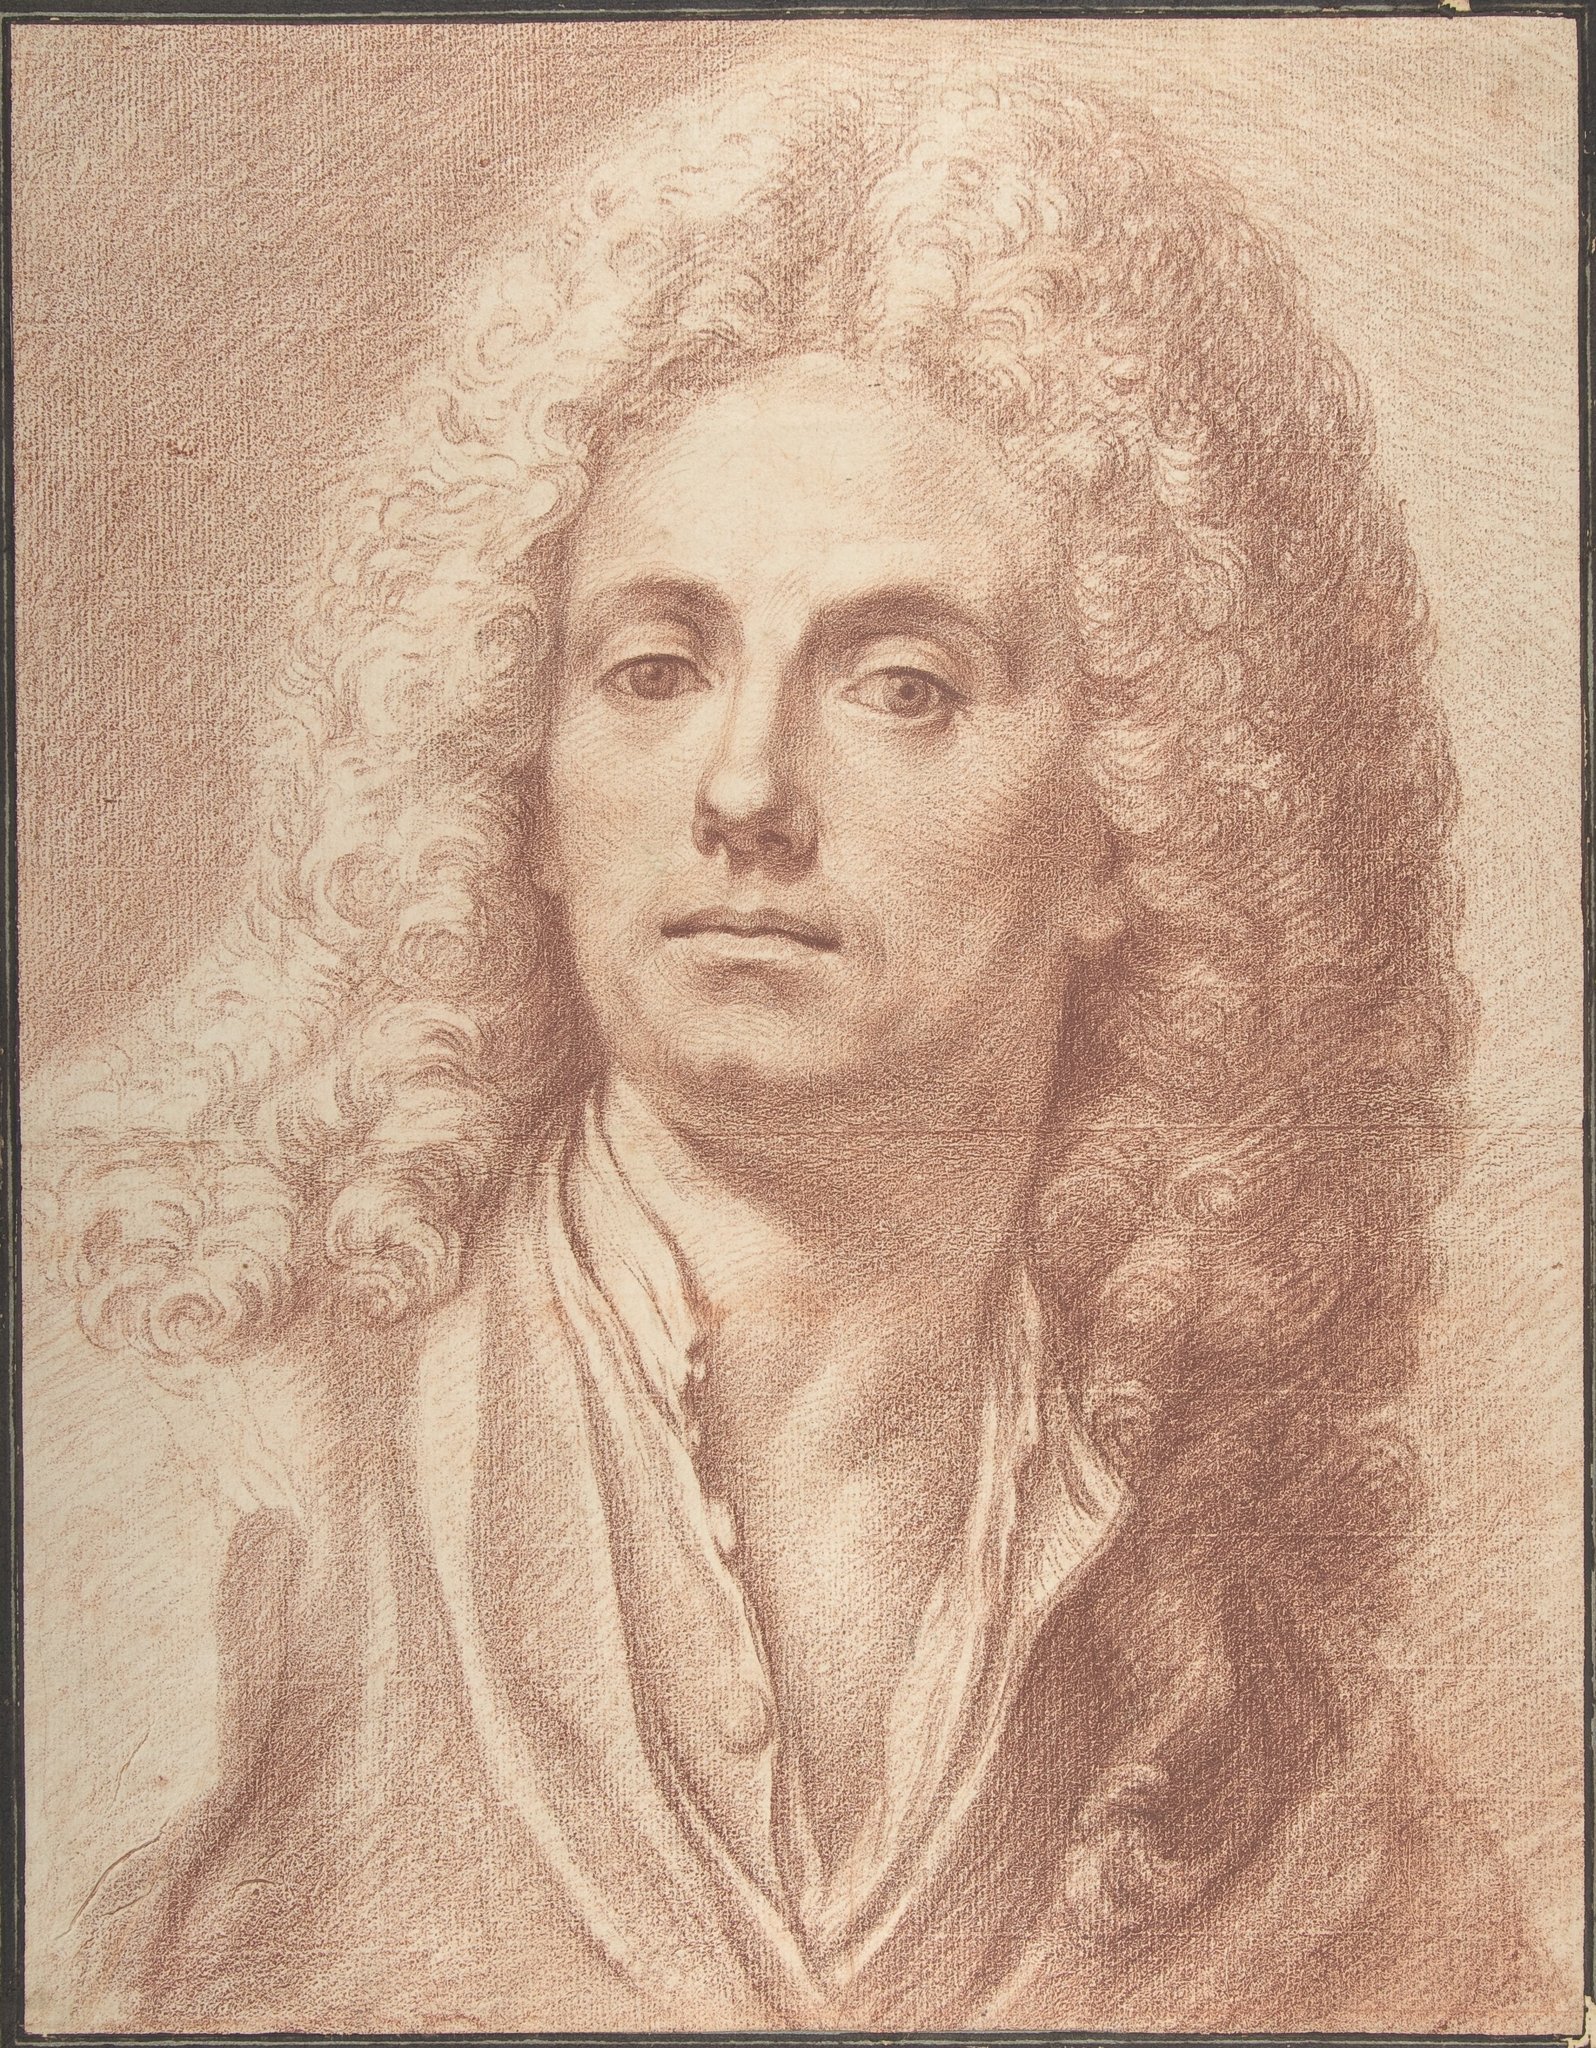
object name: drawing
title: Portrait of a Man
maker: benedetto luti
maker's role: artist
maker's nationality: italian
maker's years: 1666-1724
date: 1666-1724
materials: chalk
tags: men,portraits